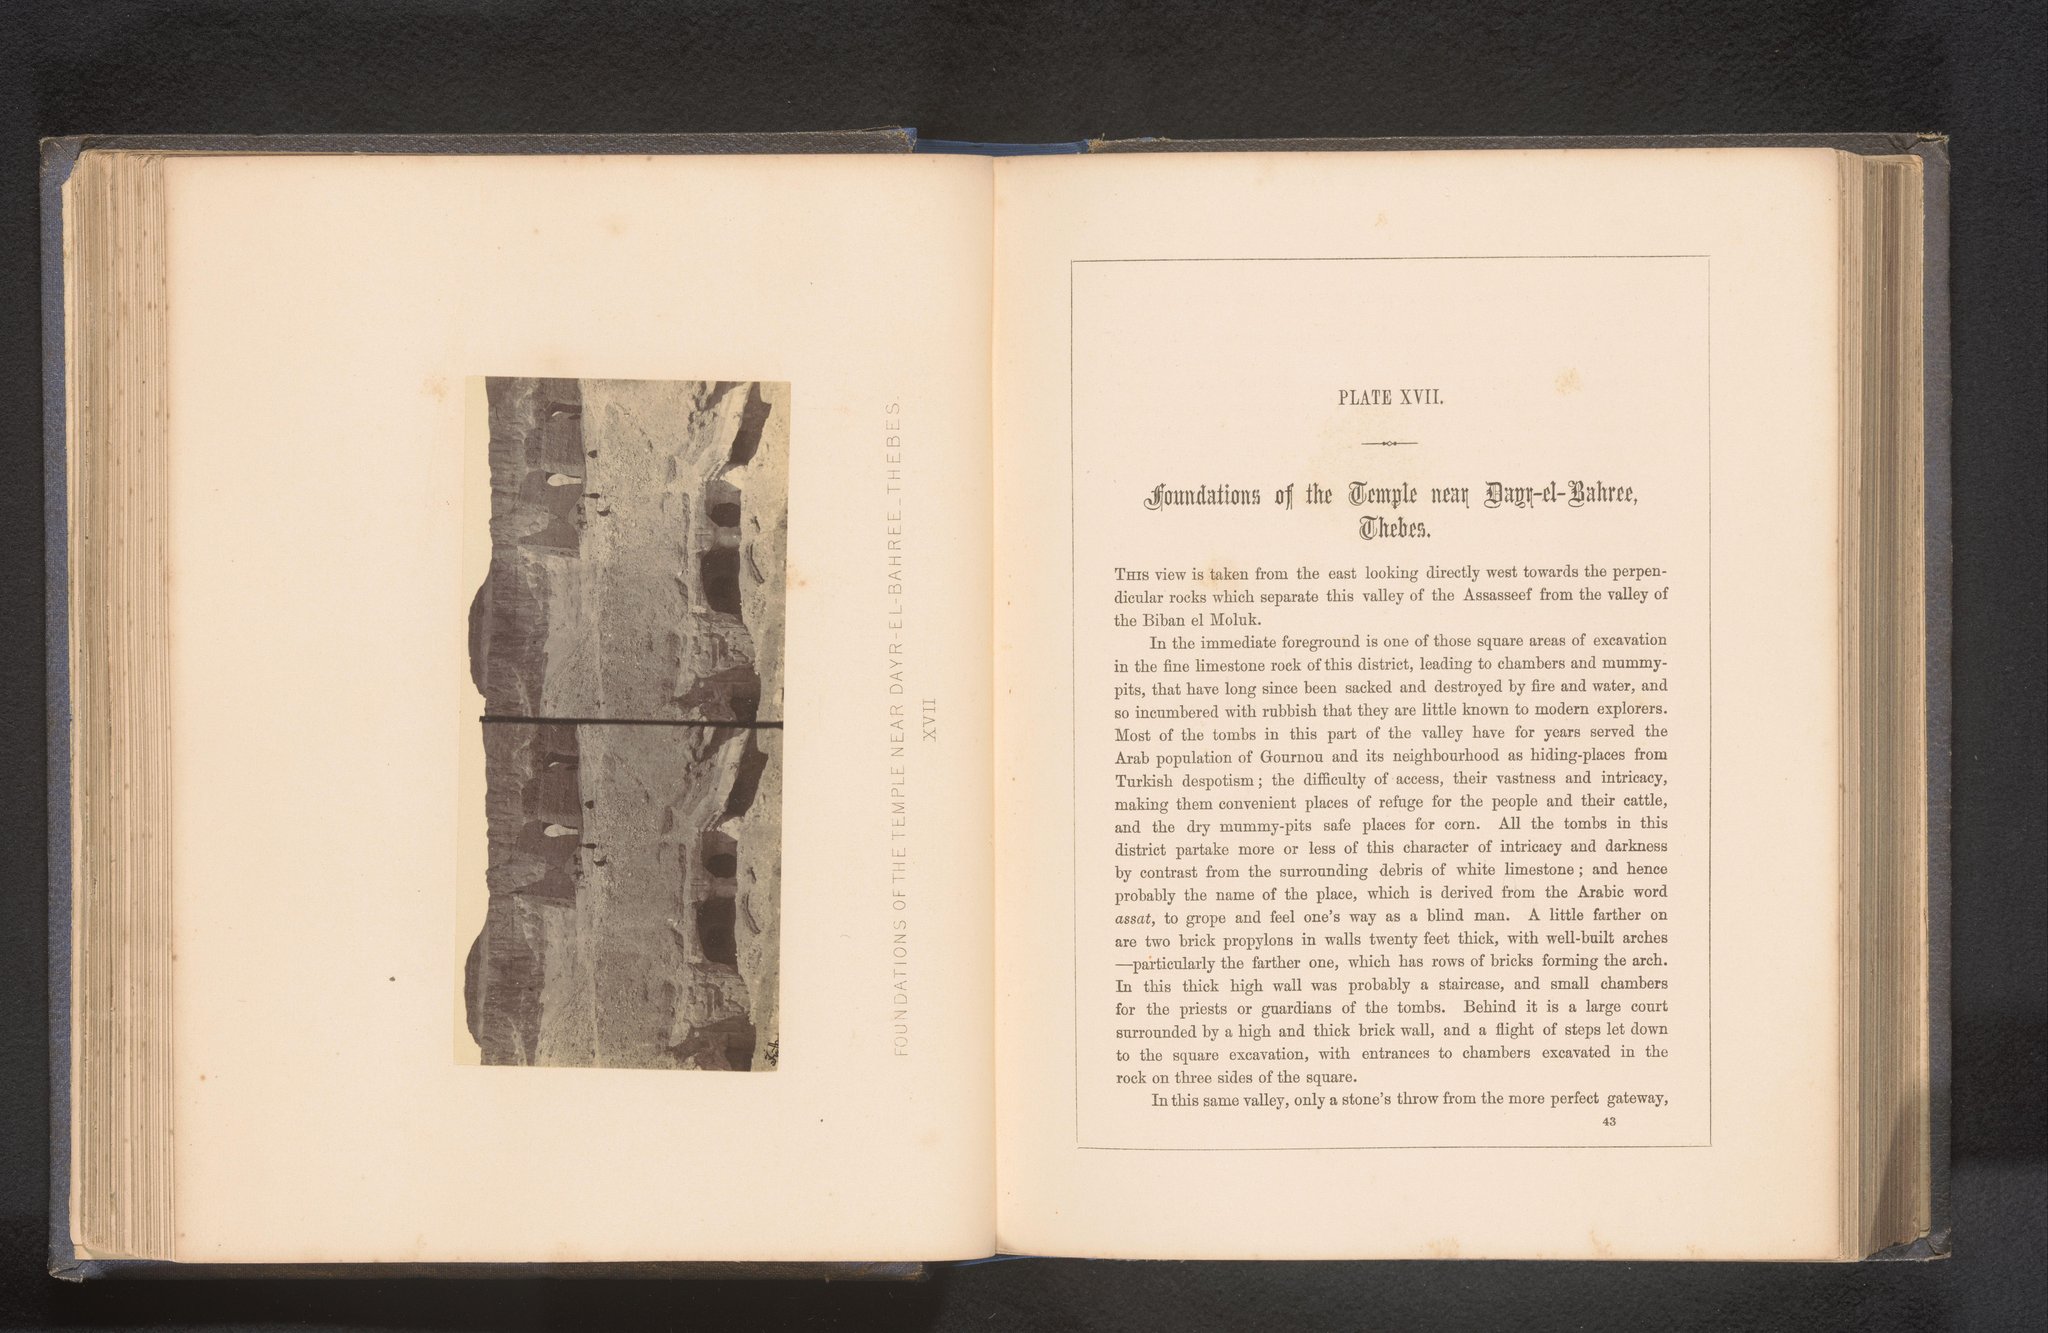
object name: page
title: Foundations of the temple near Dayr-El-Bahree - Thebes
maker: francis frith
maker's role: publisher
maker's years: 1822-1898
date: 1857-1862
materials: photographic support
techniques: albumen print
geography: deir el-bahri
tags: temple, shrine ~ egyptian religion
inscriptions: number: ‘XVII’, name: ‘Frith’